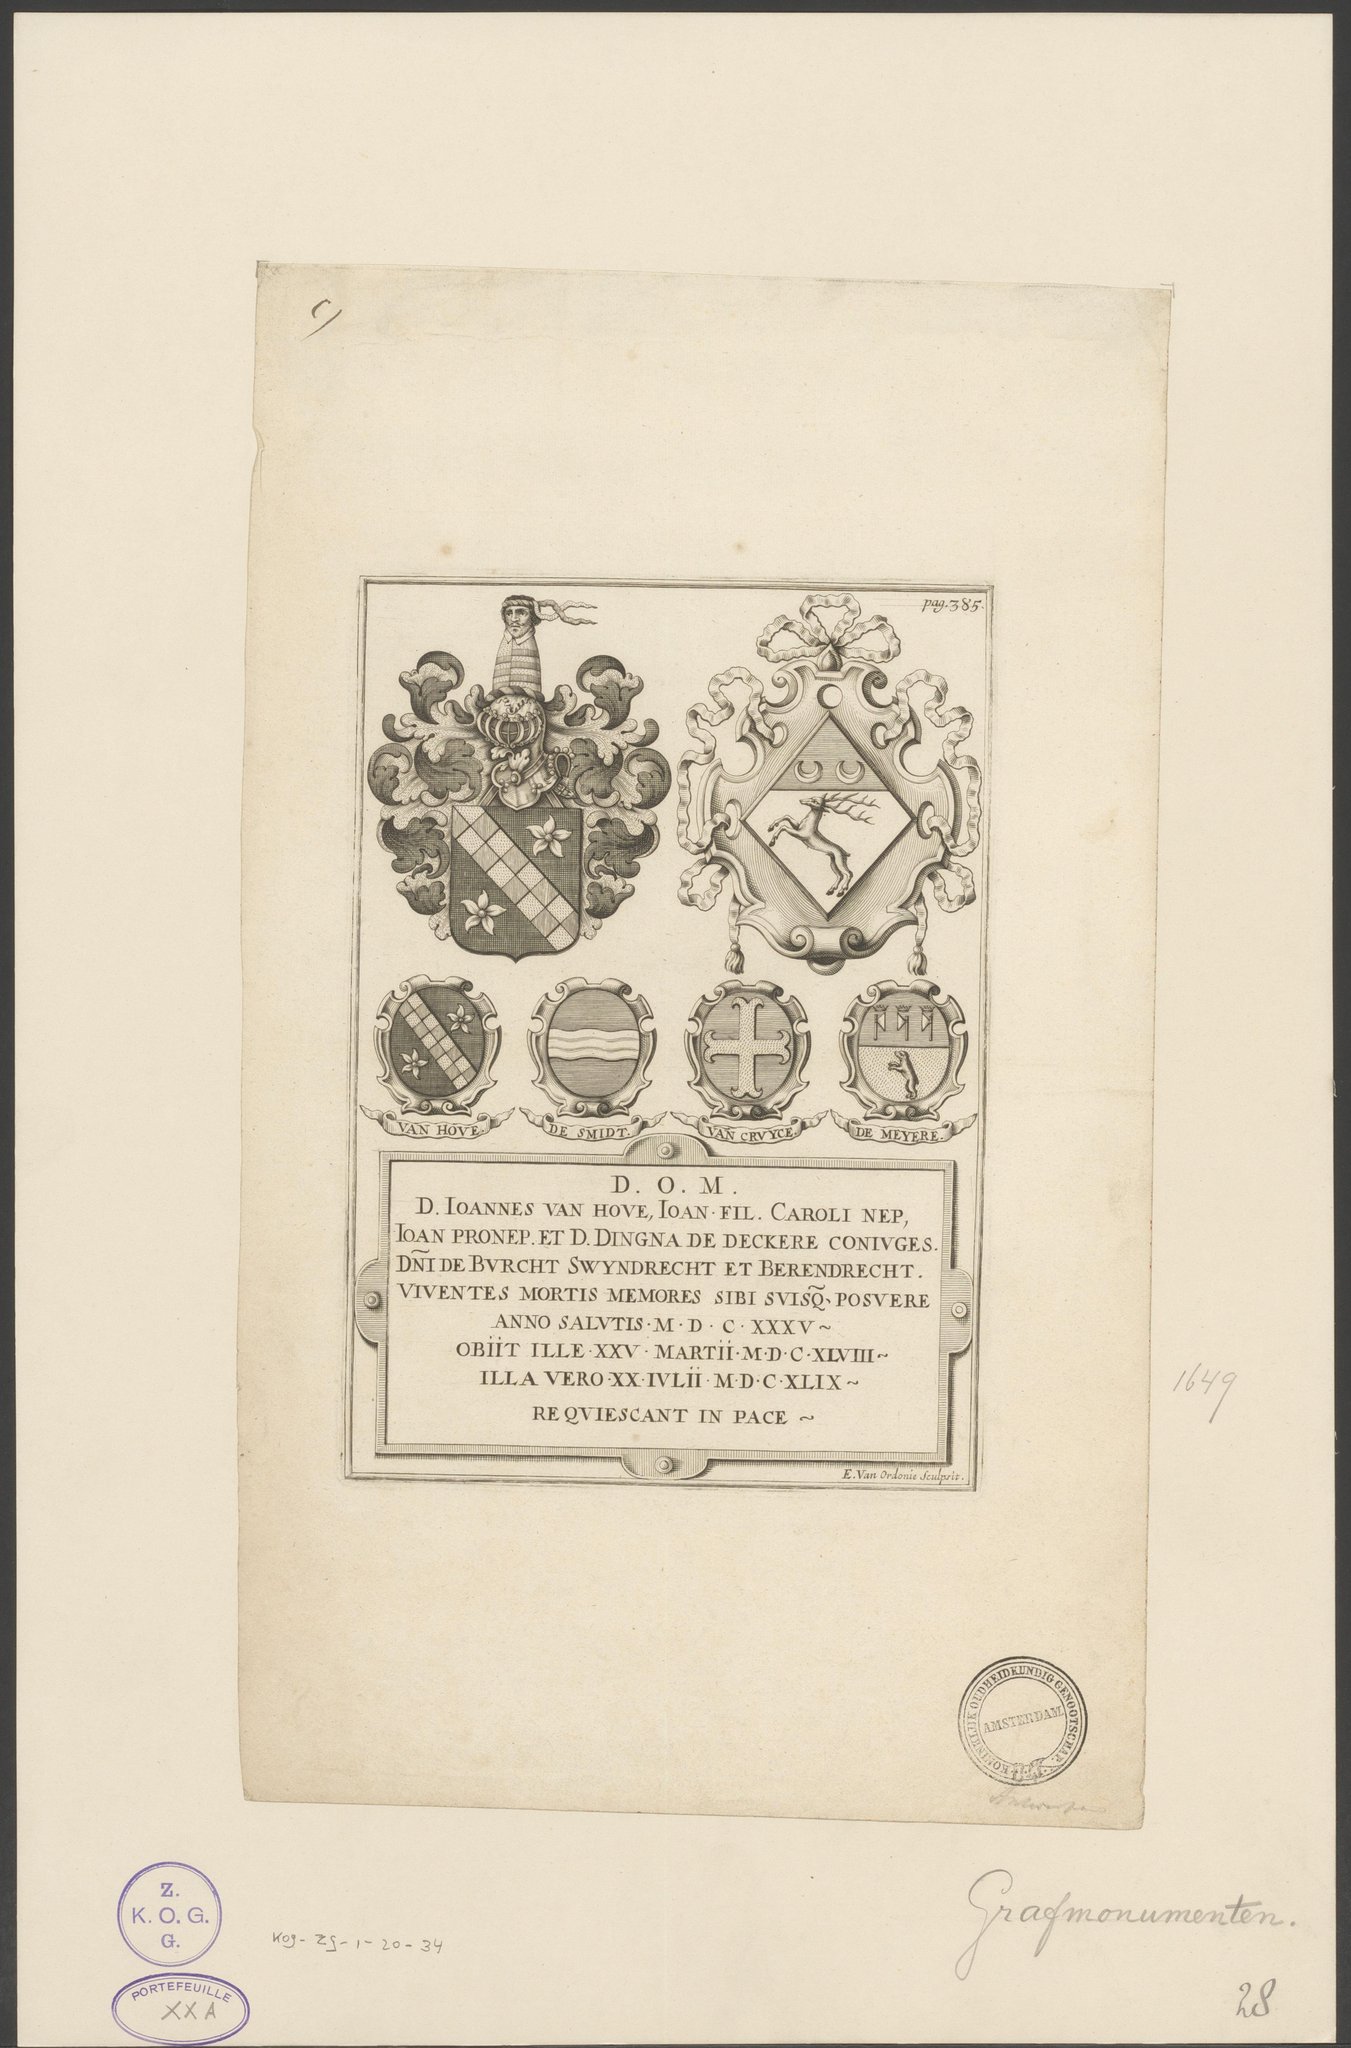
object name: print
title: Grafsteen van Joannes van Hove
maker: edouard van ordonie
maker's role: print maker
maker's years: 1638-1695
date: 1678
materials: paper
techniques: engraving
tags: gravestone, tombstone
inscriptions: stamp: ‘Koninklijk Oudheidkundig Genootschap Amsterdam’, stamp, collector's mark: Lugt 1641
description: Rechtsboven genummerd: pag. 385. Onderwerpsrubrieken binnen de Atlas Zeden en Gewoonten: Zeden en Gewoonten in Engeren Zin, Des menschen beging, midden en einde, Grafmonumenten.